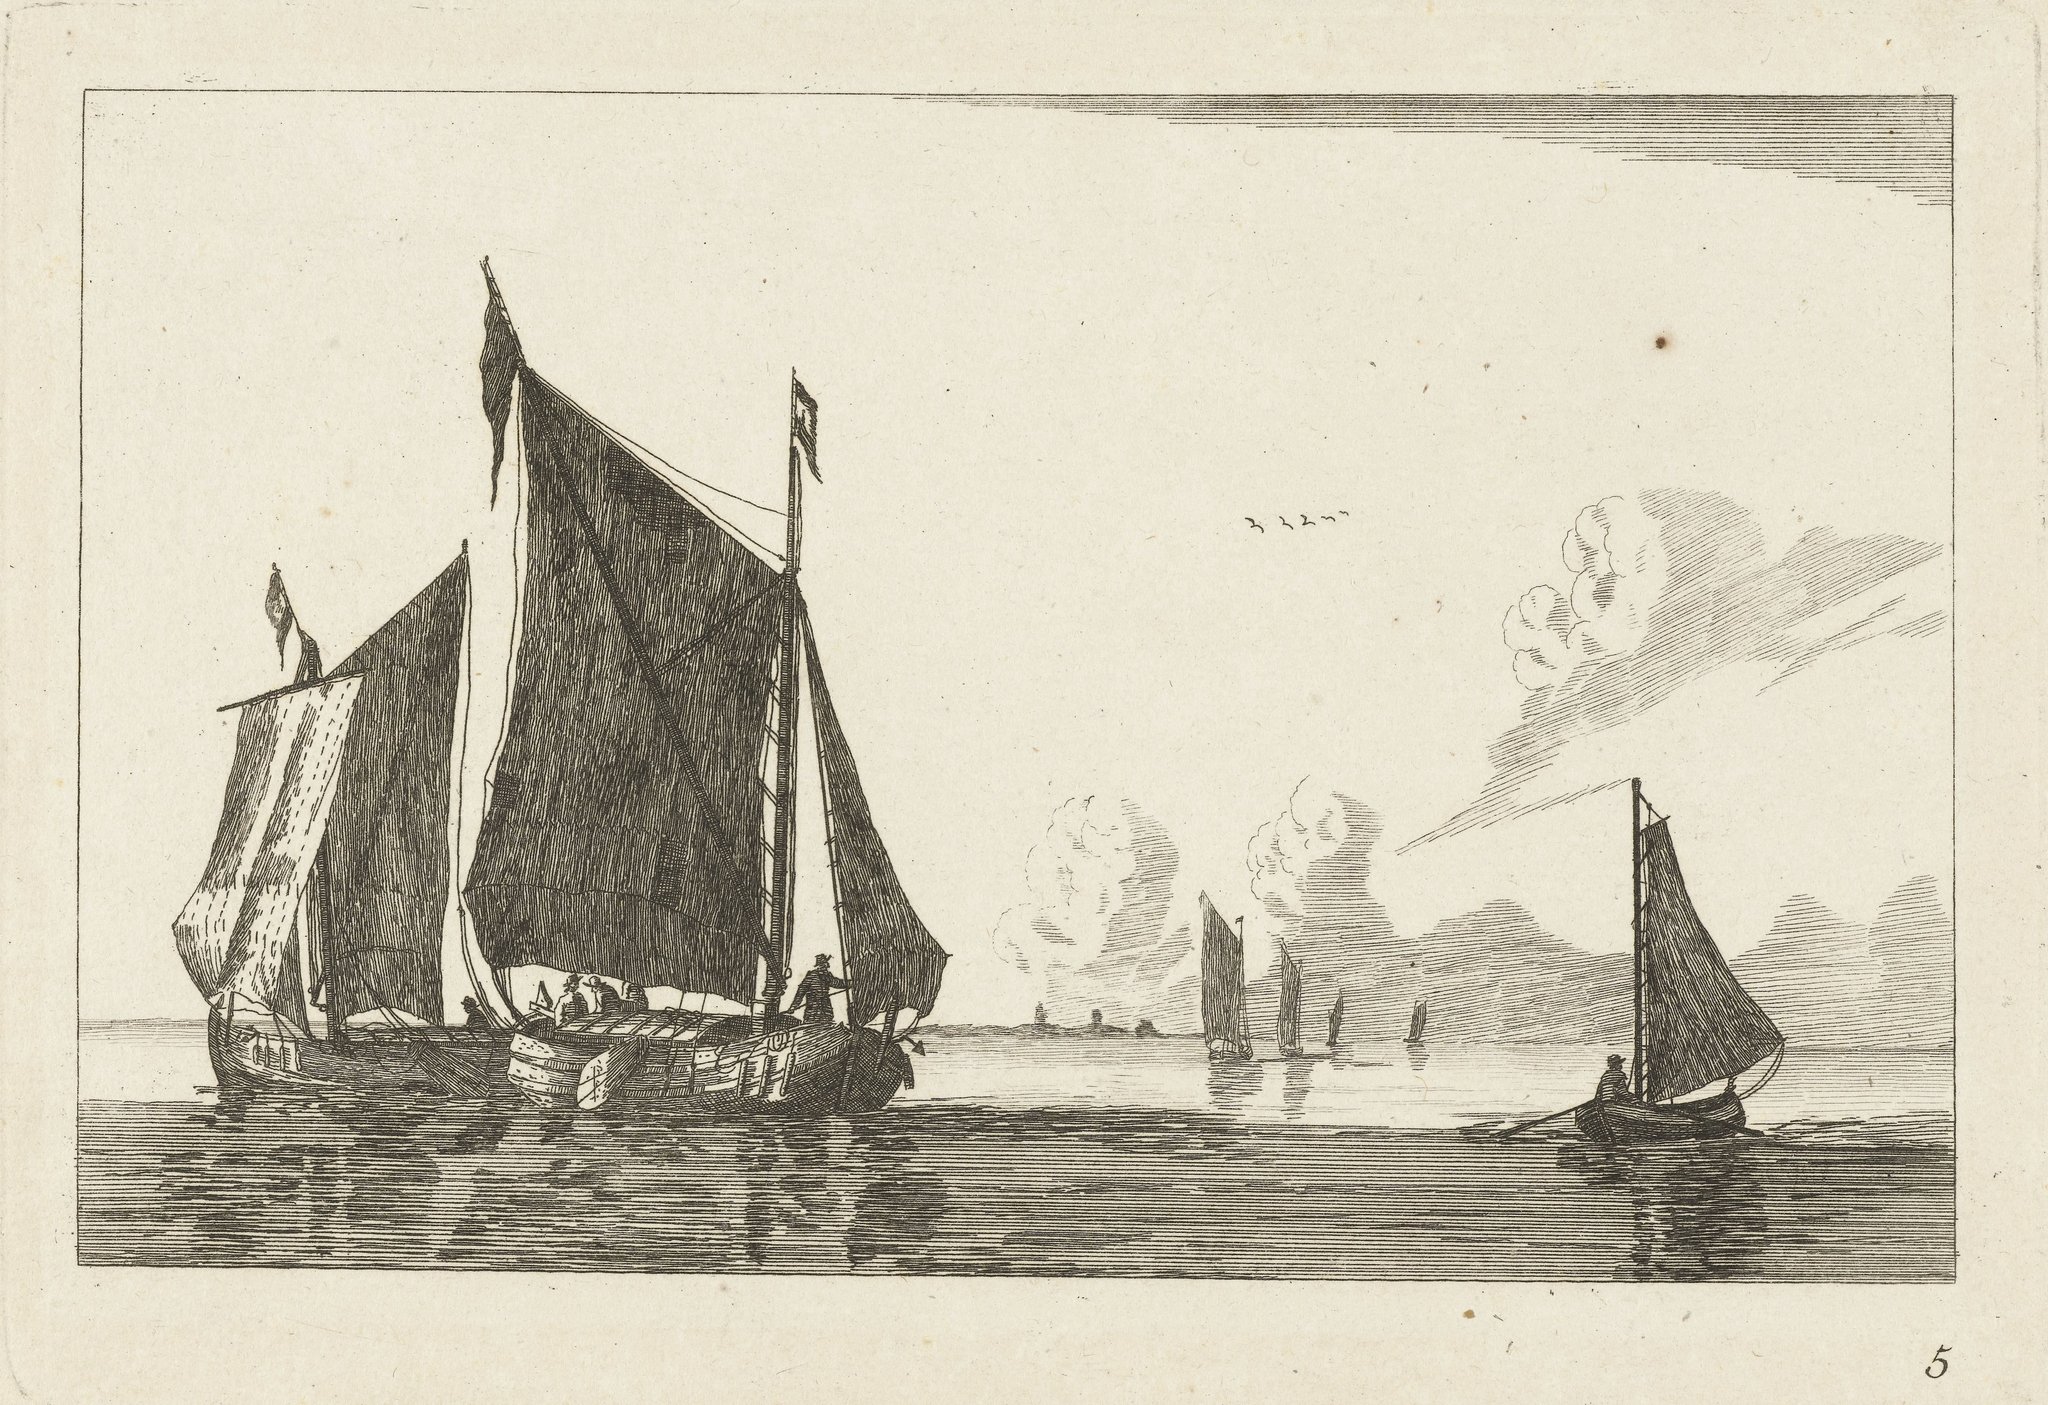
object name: print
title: Drie zeilschepen in kalm water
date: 1700-1799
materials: paper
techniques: etching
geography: paris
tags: sailing-ship, sailing-boat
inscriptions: collector's mark: Lugt 2228a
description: Twee zeilschepen en een kleine roeiboot met een zeil, op kalm water. In de verte nog een aantal zeilschepen. Kopie in spiegelbeeld.